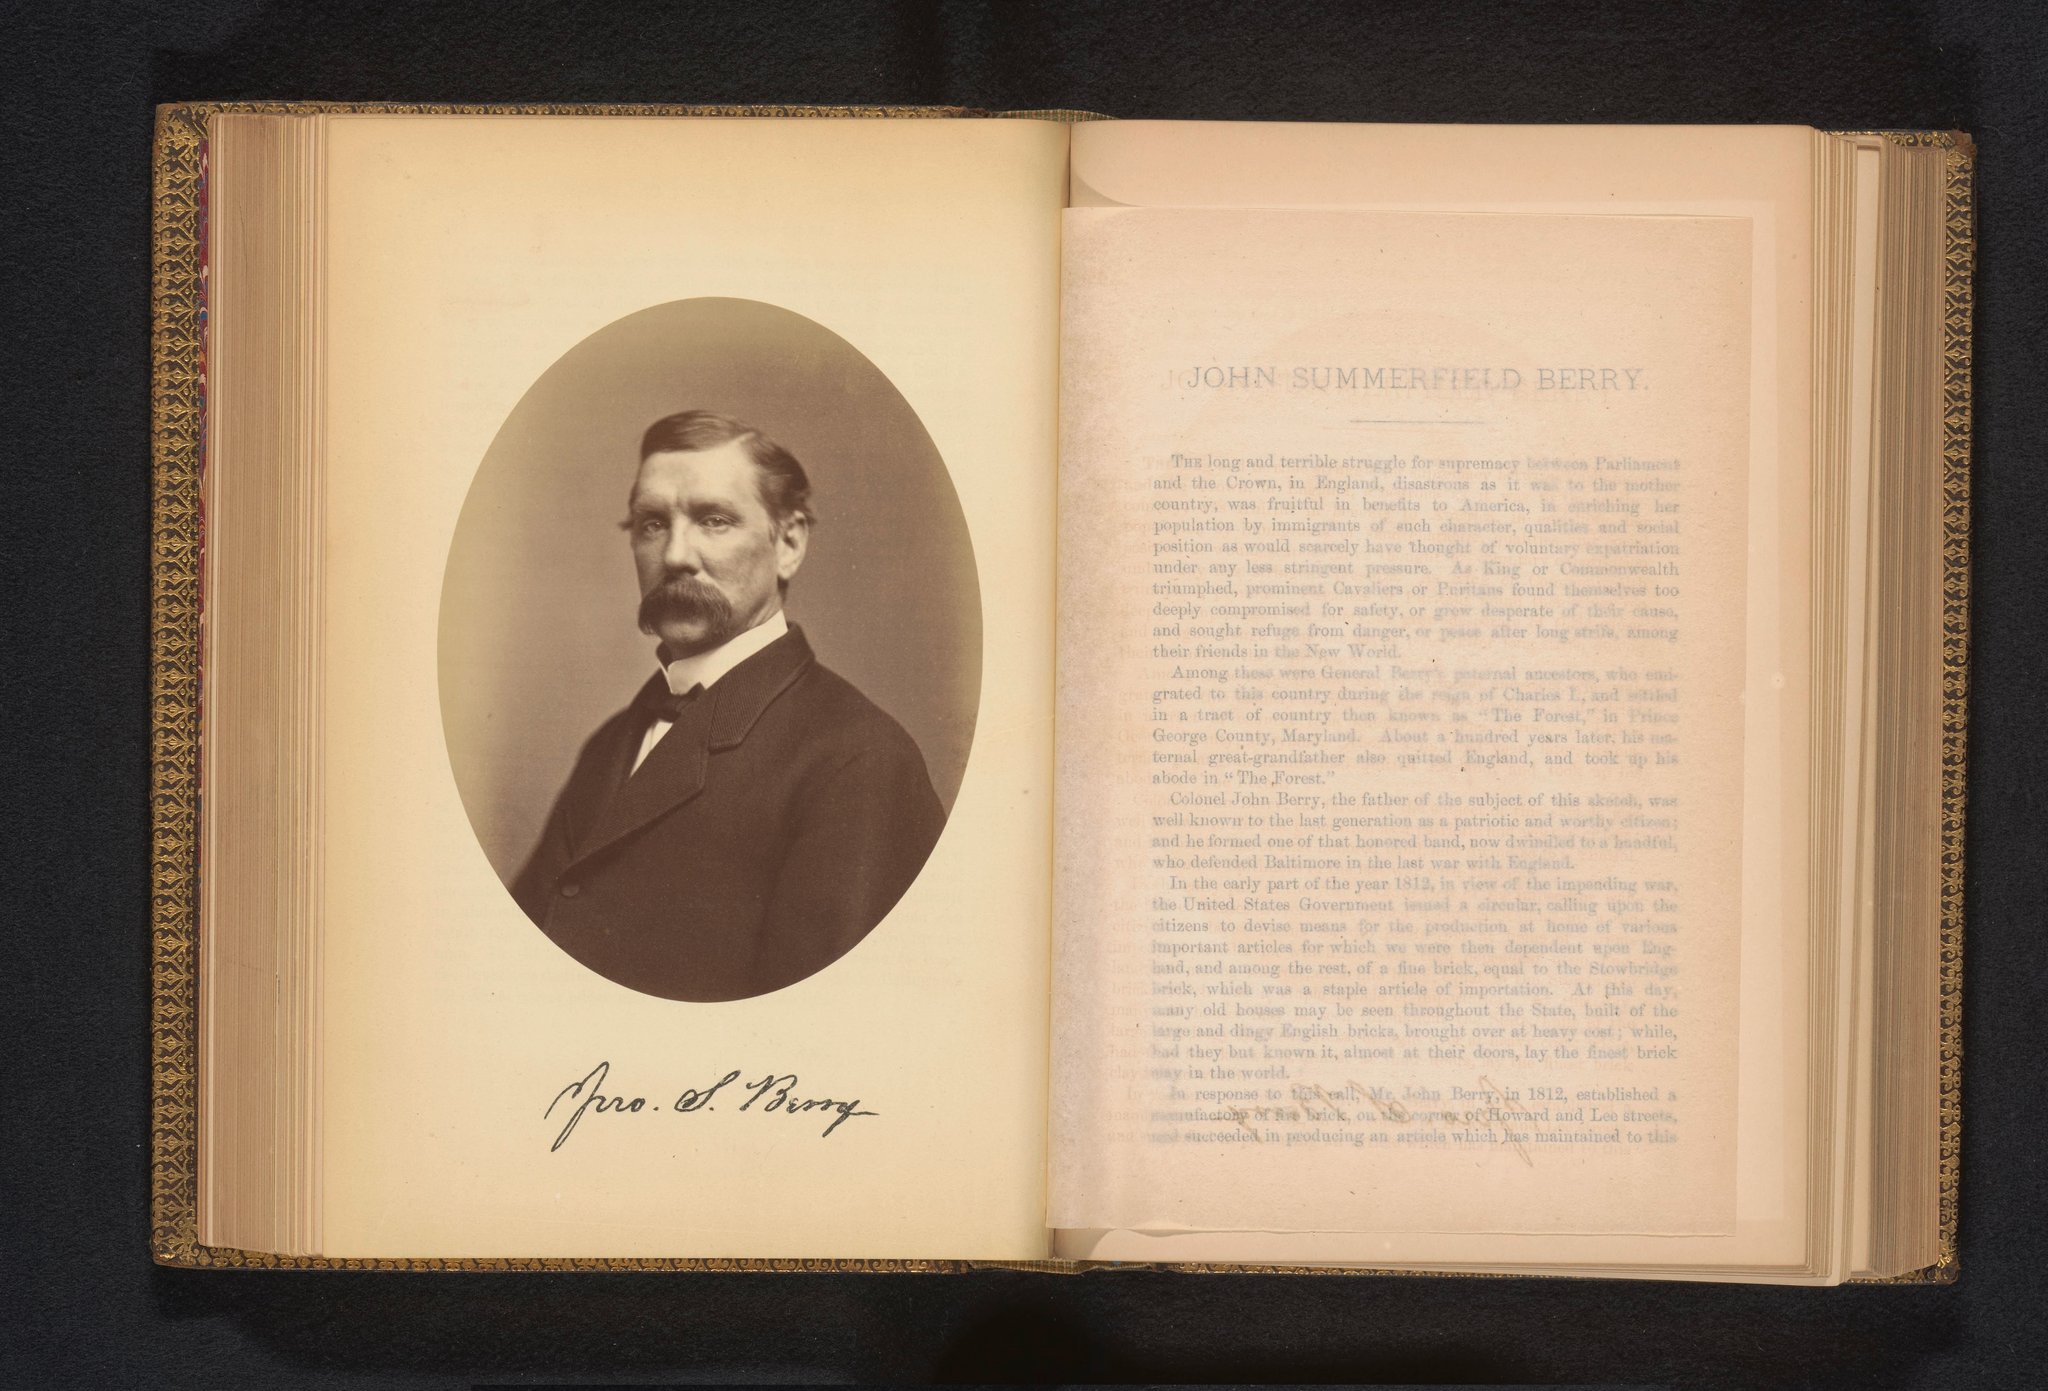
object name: photograph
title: John S. Berry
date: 1866-1871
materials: photographic support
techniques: albumen print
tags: historical persons